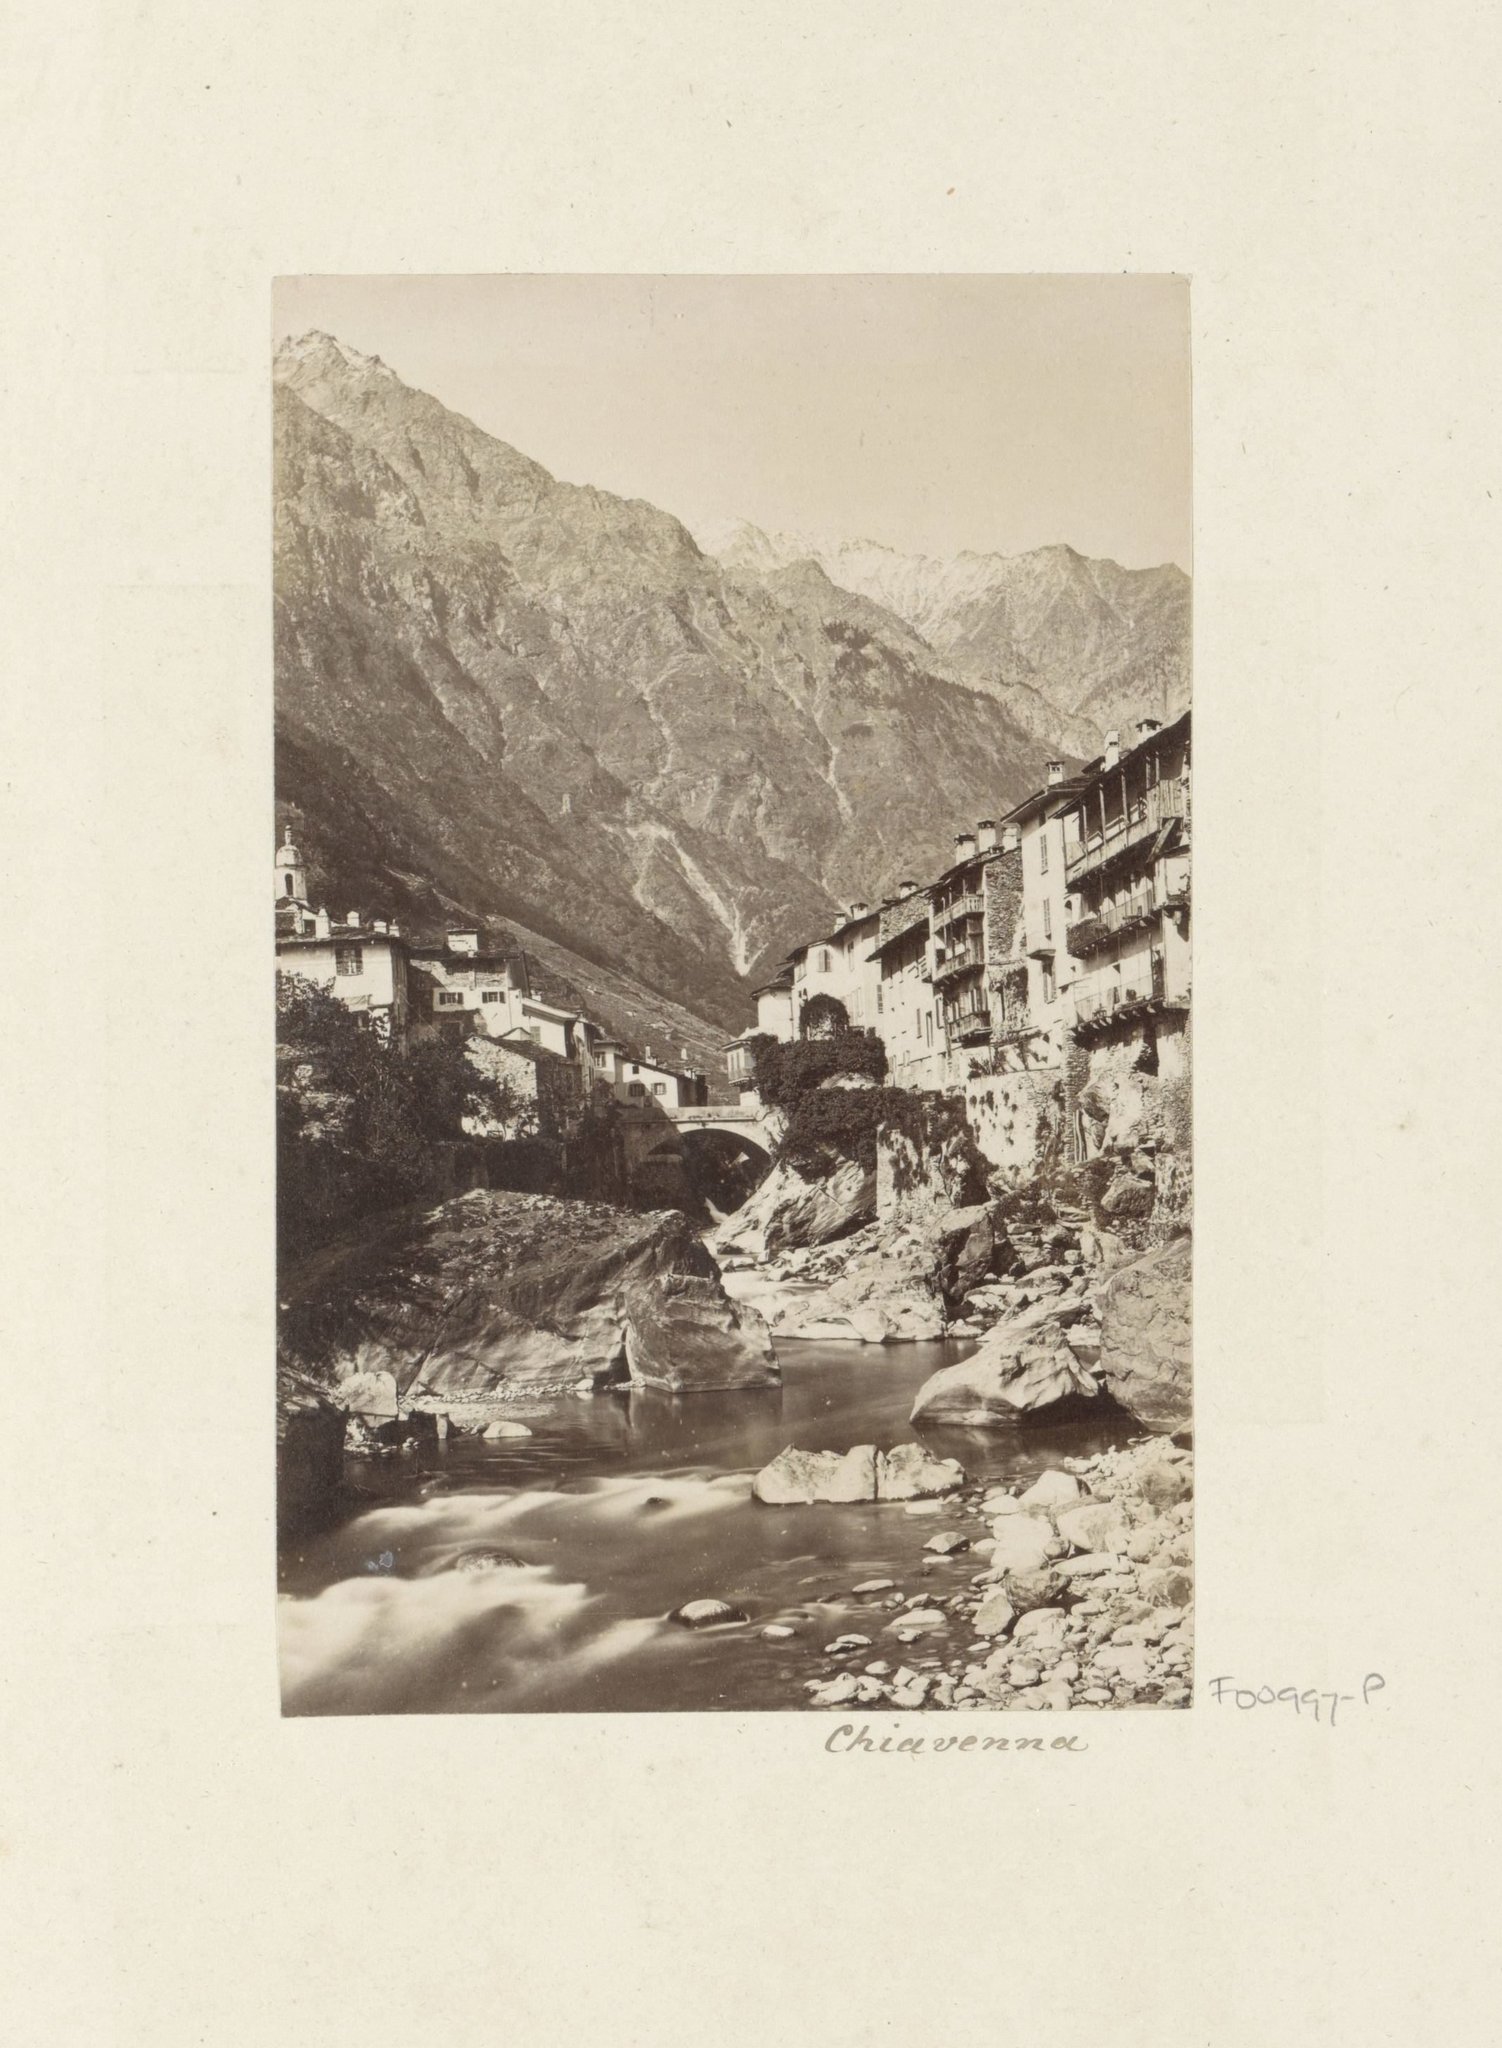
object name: photograph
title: Bergdorp Chiavenna gezien vanaf een beek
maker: Anonymous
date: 1860-1890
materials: paper, photographic support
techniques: albumen print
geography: chiavenna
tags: prospect of village, silhouette of village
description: Onderdeel van Reisalbum met foto's van Zwitserland, Oostenrijk, Italië en Duitsland.